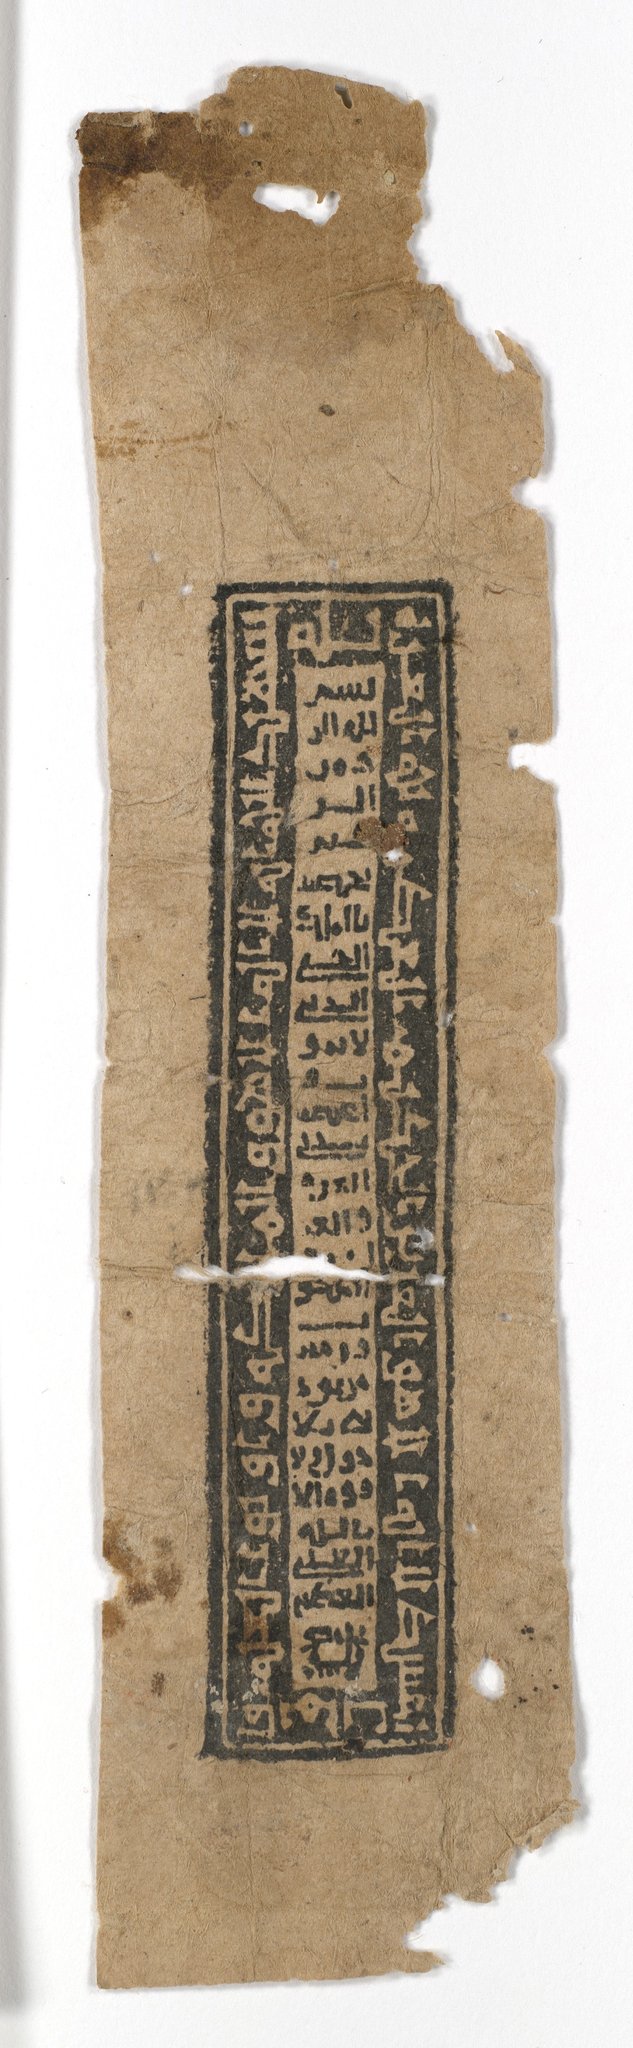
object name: scroll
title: Talismanic Scroll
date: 1001-1200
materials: ink, paper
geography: egypt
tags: scrolls